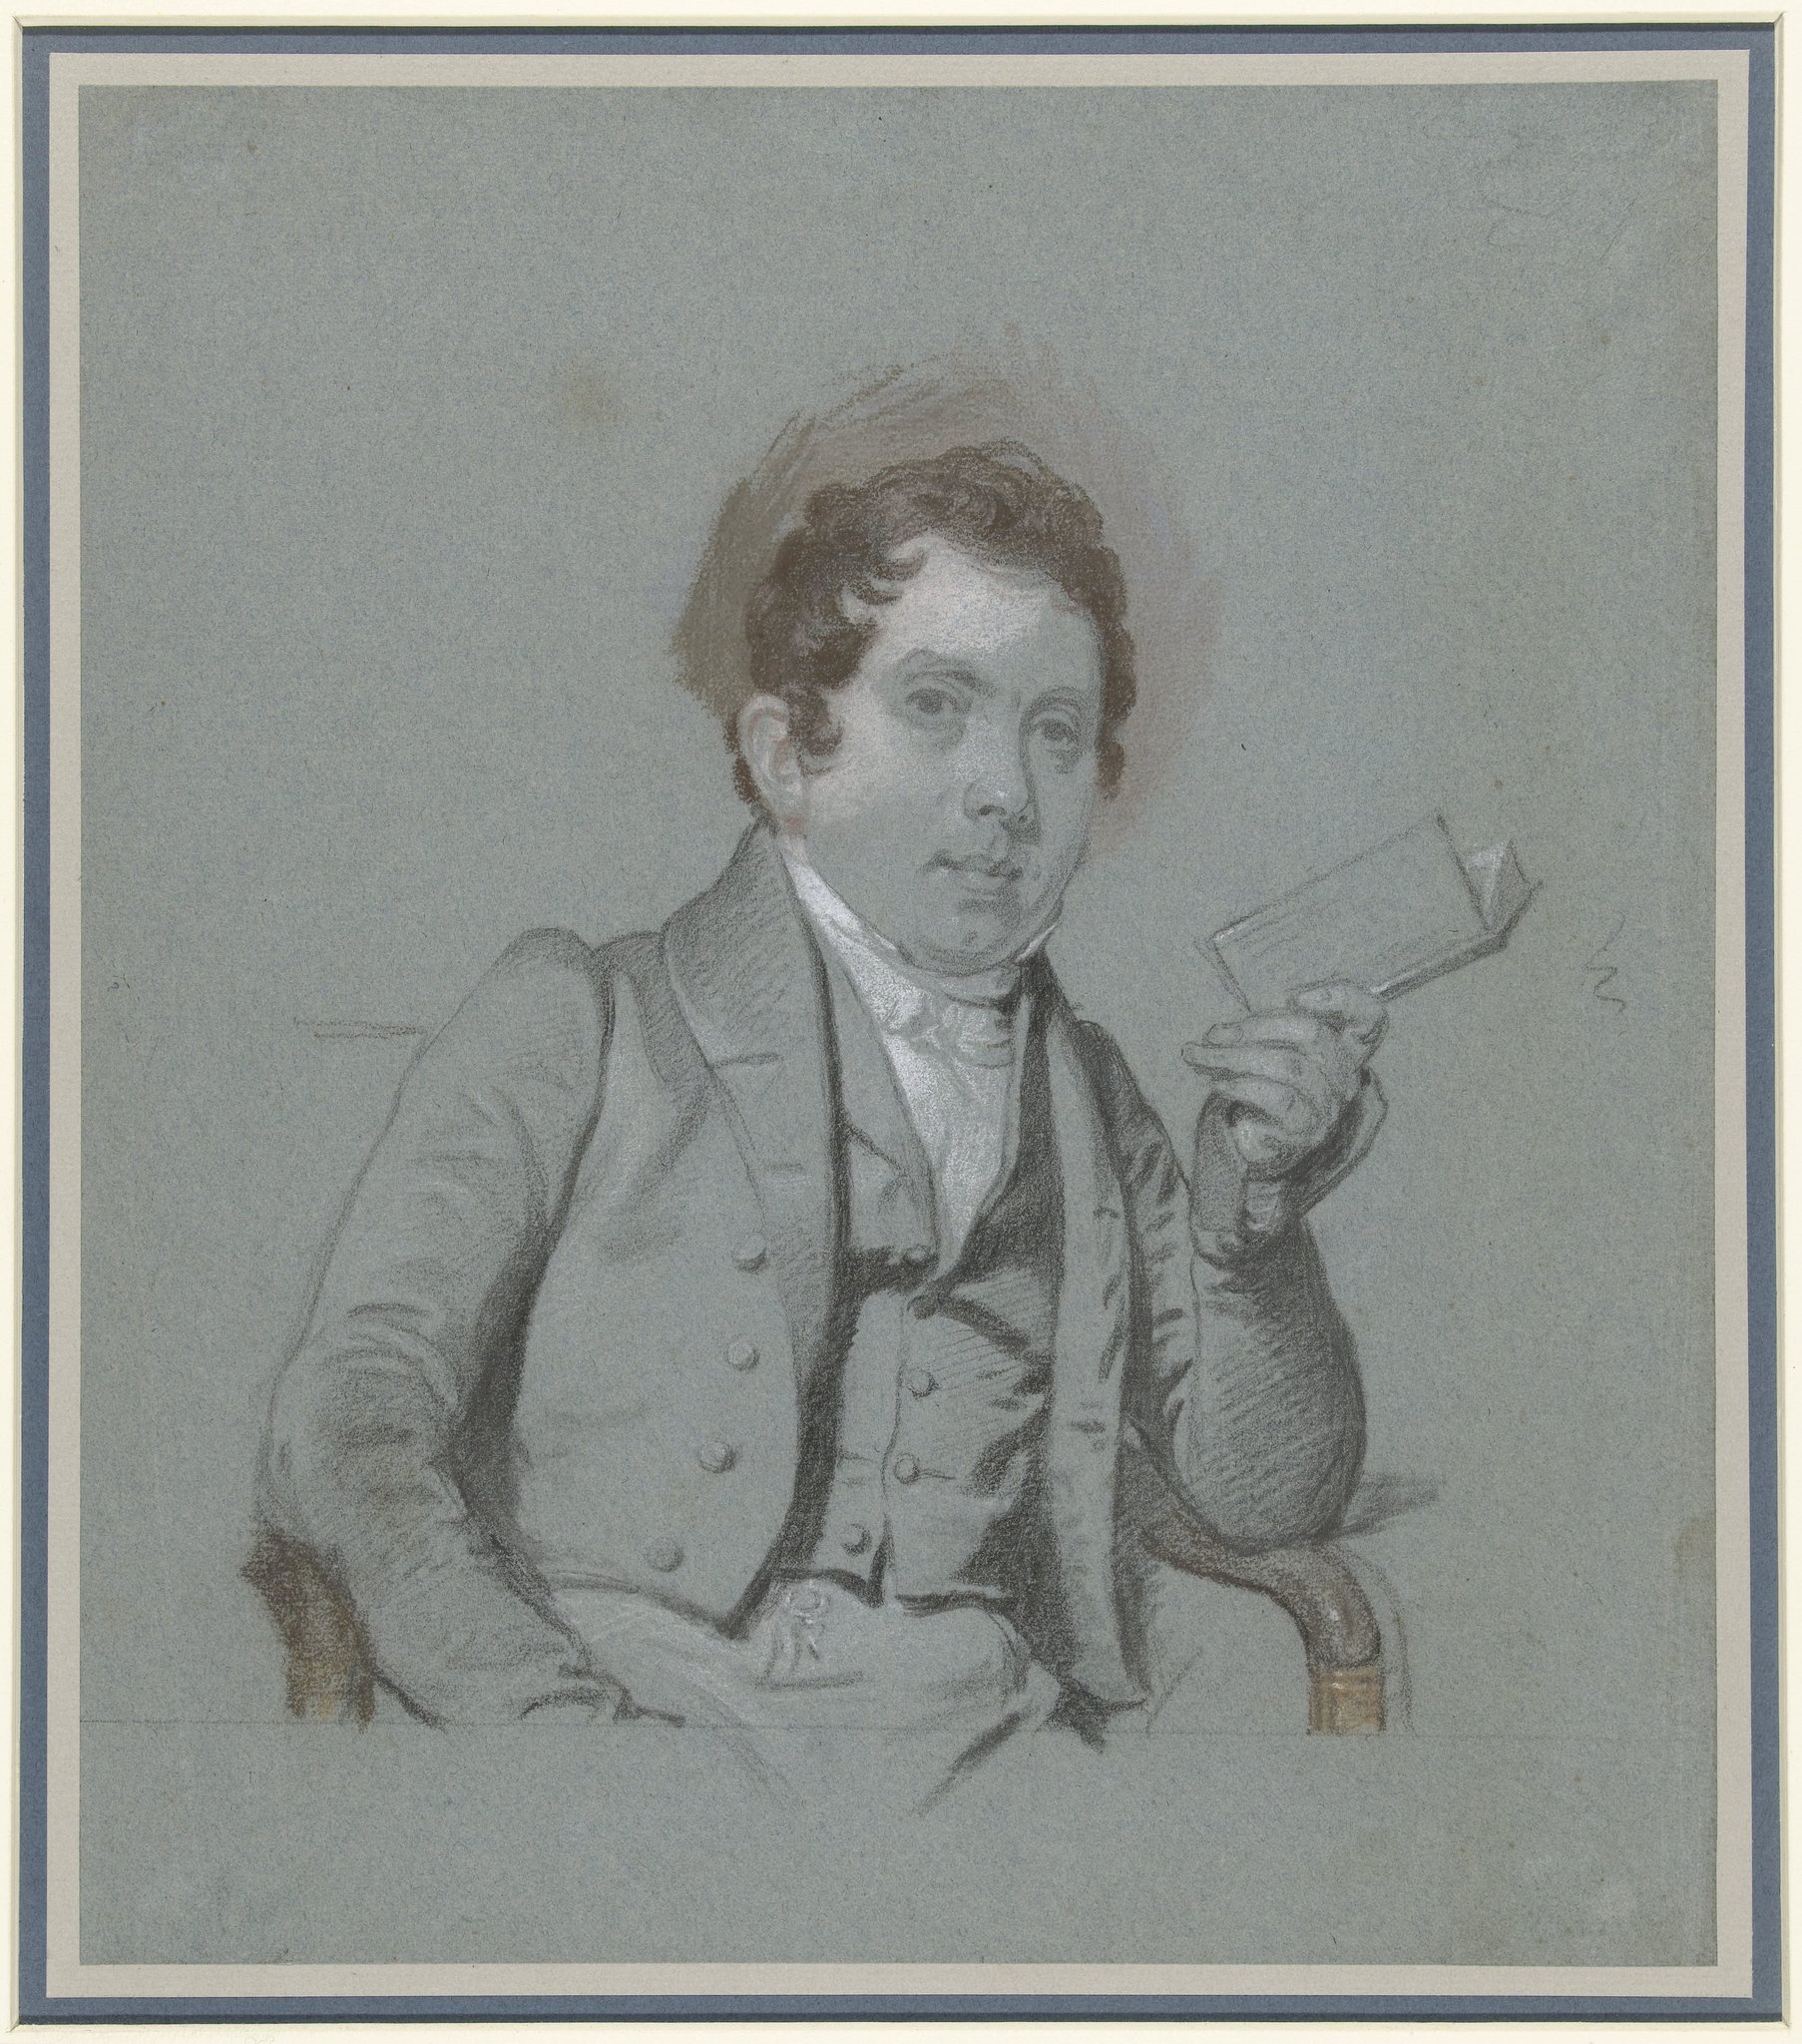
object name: drawing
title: Portret van een onbekende man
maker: charles howard hodges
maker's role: draughtsman, painter, print maker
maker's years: 1764-1837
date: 1774-1837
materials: chalk, paper, pastel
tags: anonymous historical person portrayed alone